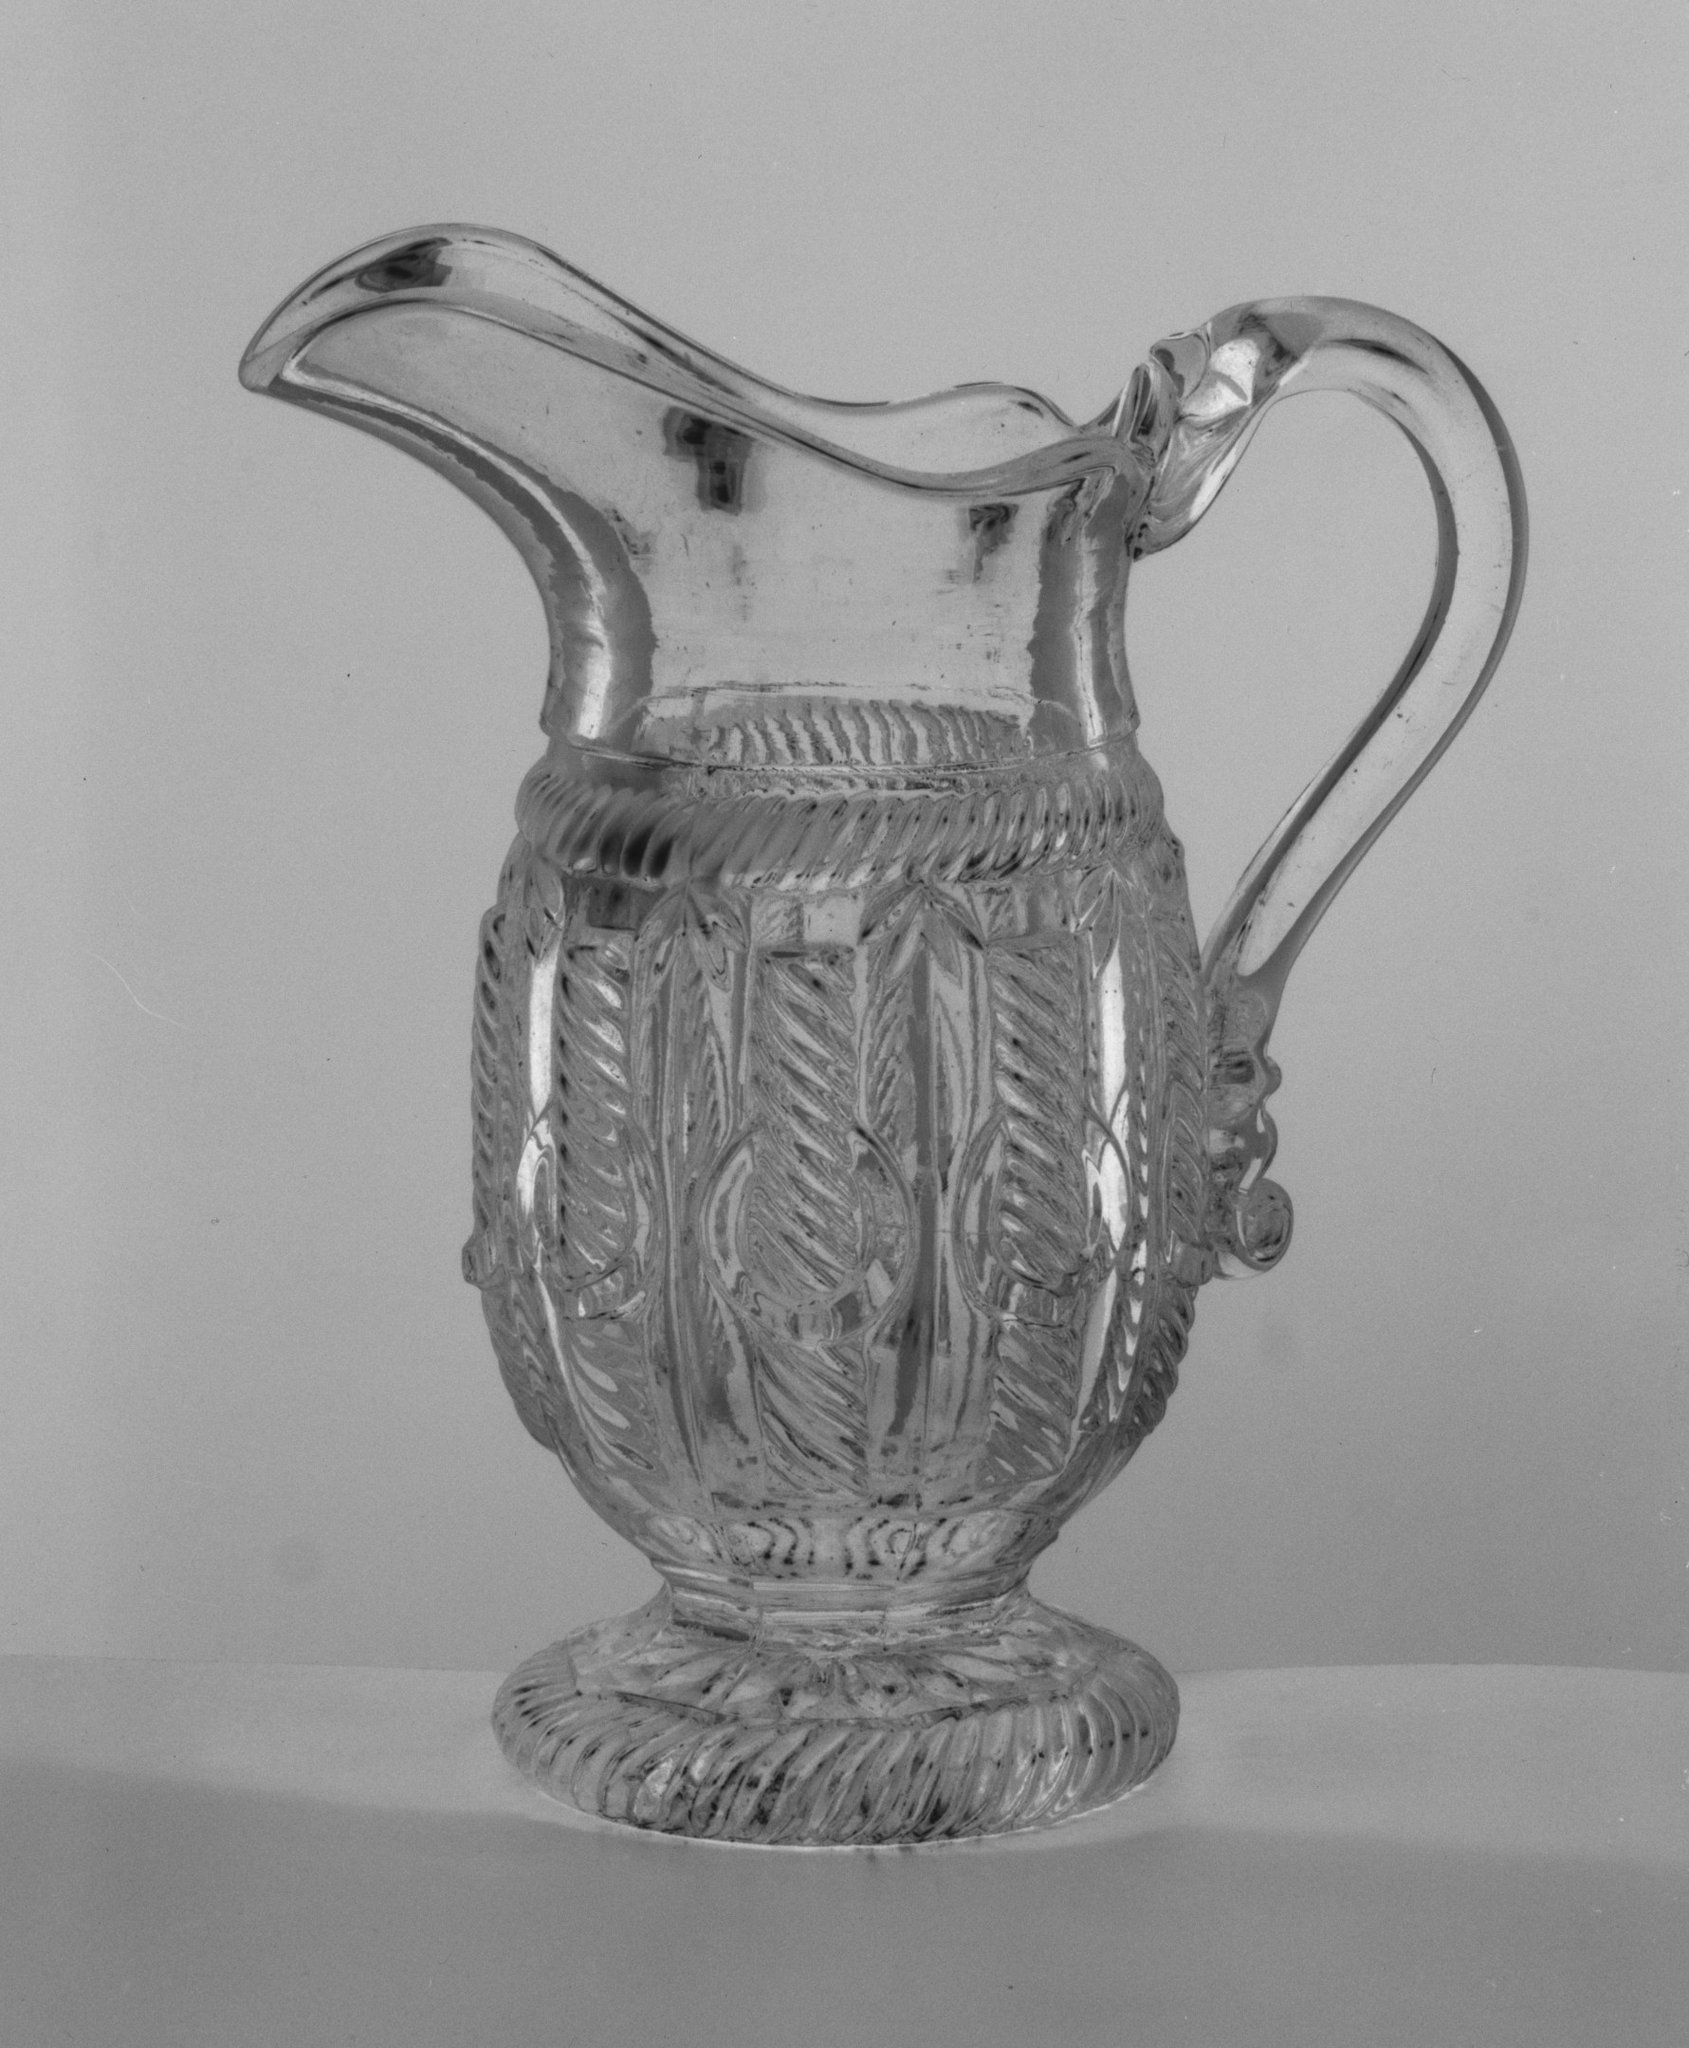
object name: pitcher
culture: american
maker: boston & sandwich glass company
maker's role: maker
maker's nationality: american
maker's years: 1825-1888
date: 1866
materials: glass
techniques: pressed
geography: united states